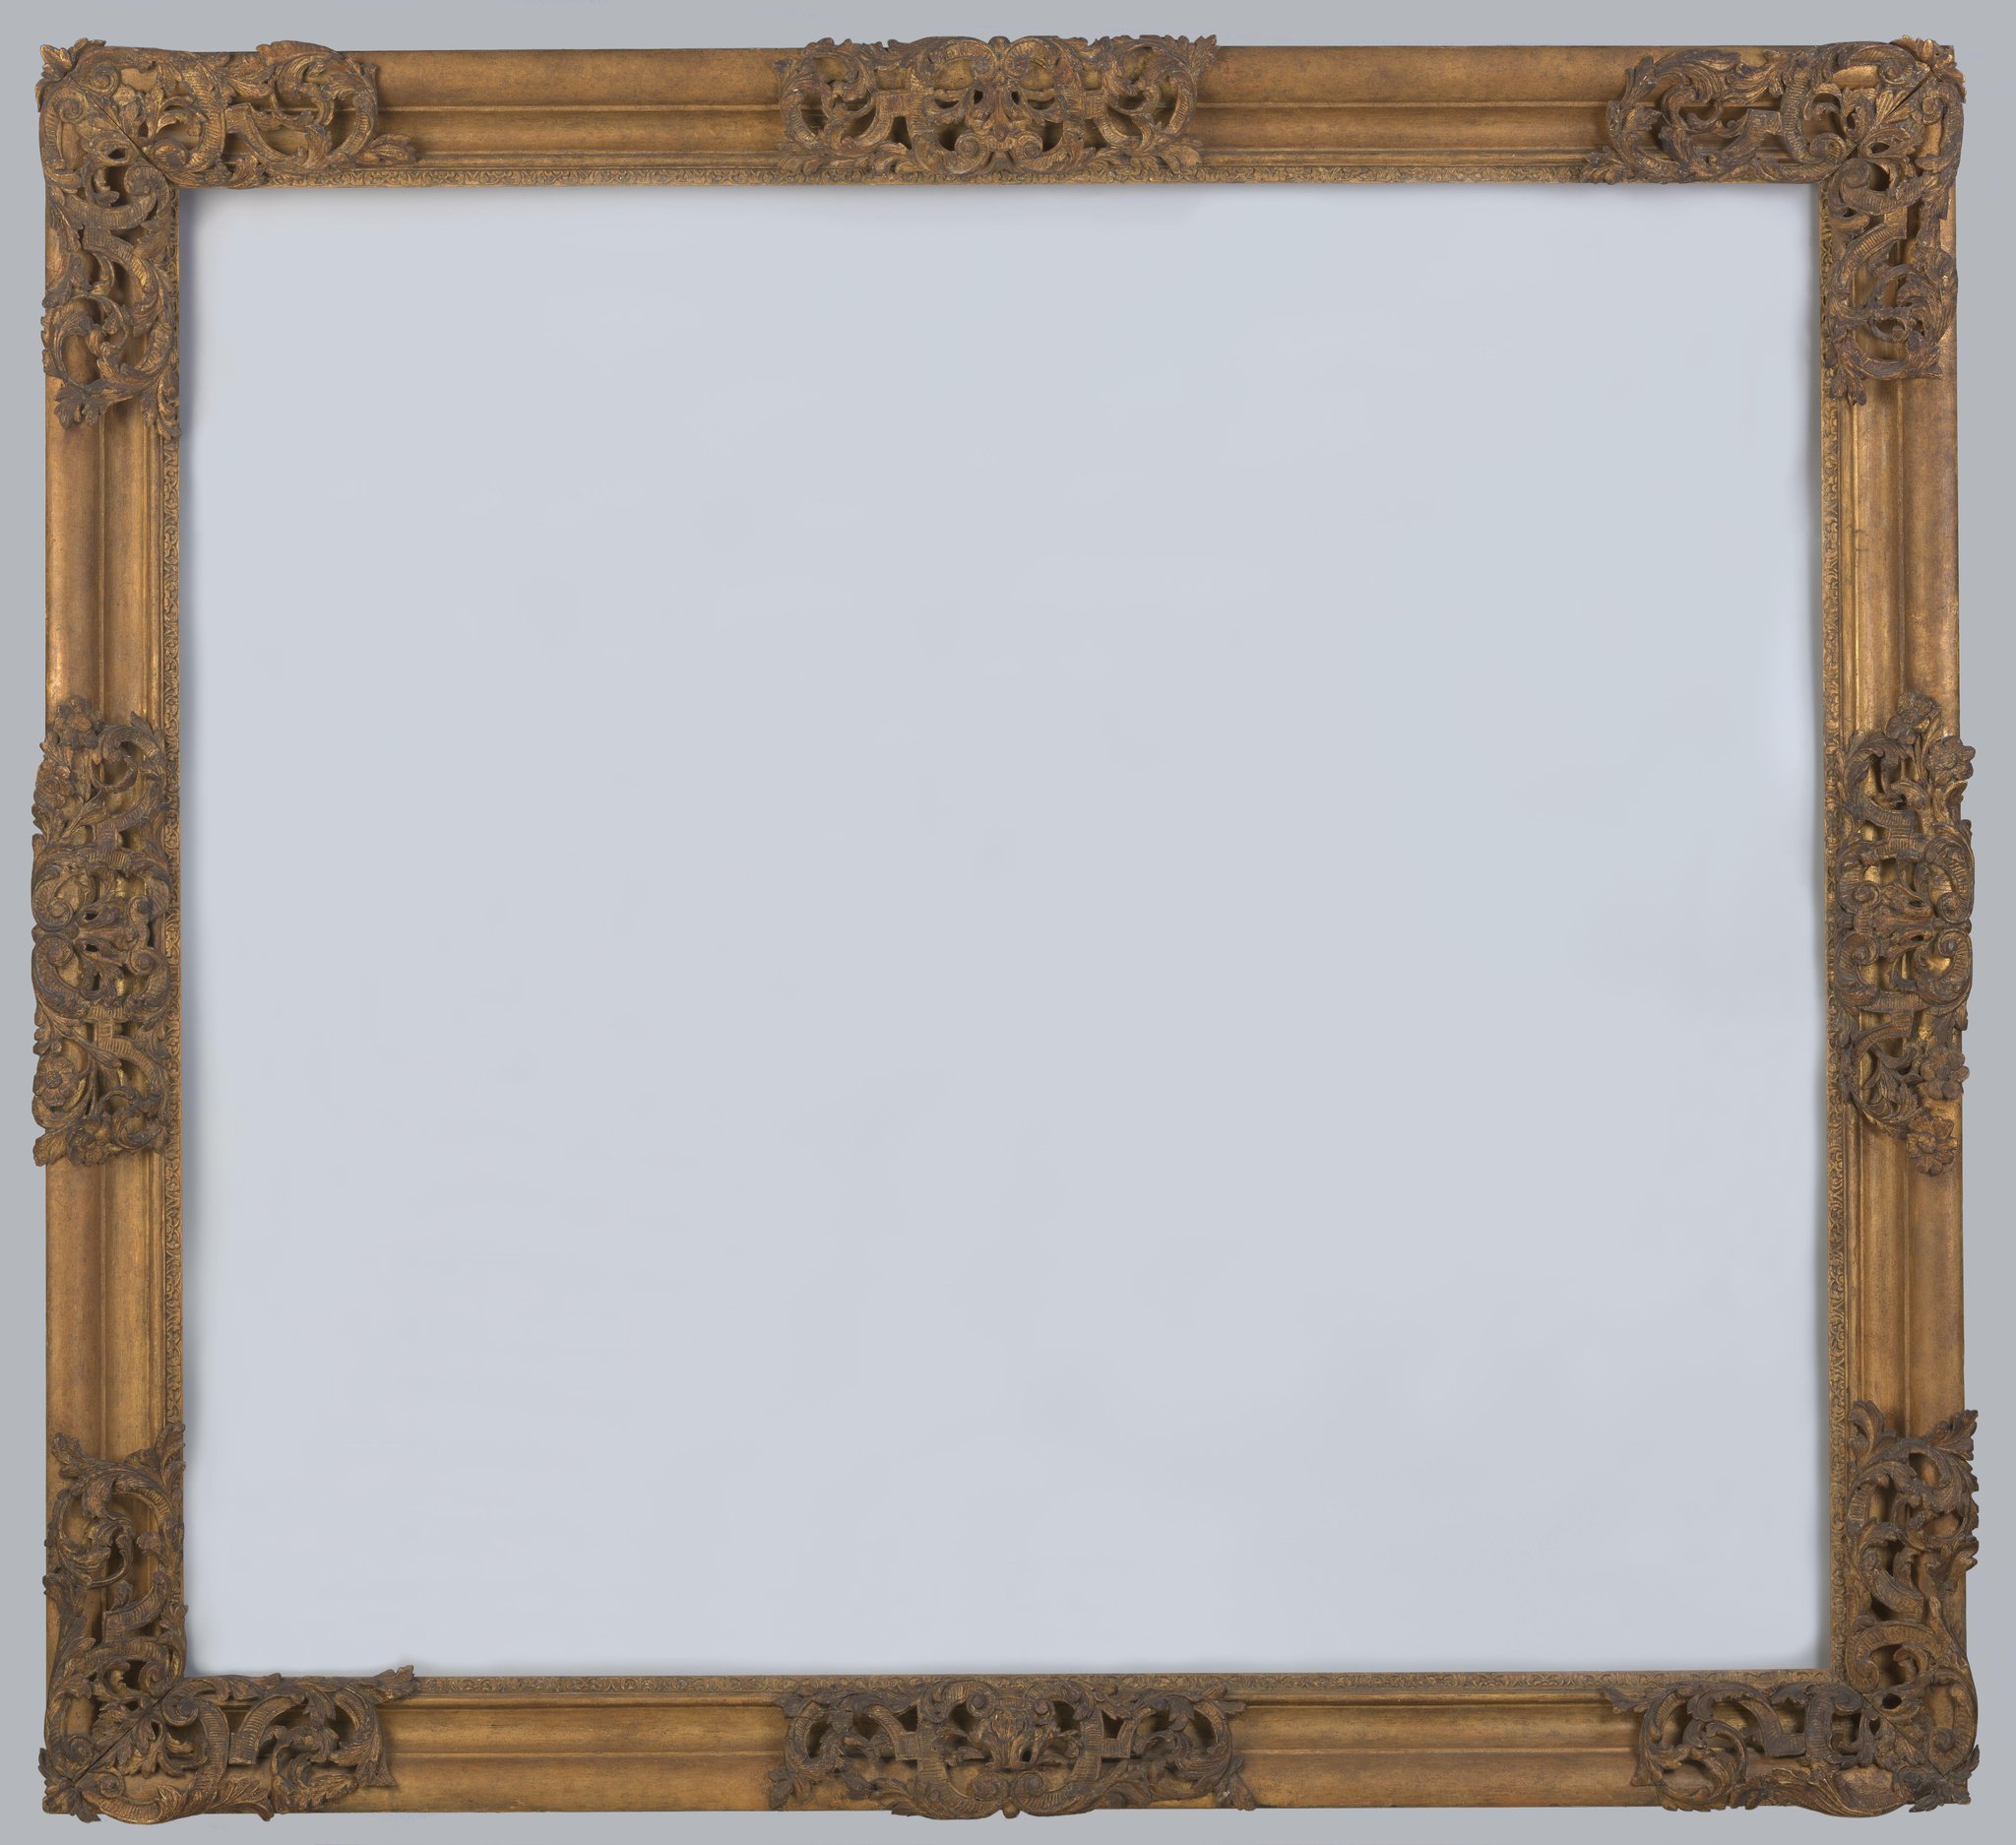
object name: frame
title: Vergulde lijst met gesneden en opengewerkte ornamenten.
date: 1800-1899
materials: gold leaf, wood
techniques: cutting, gilding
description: vergulde schilderijlijst met houtgesneden ornamenten